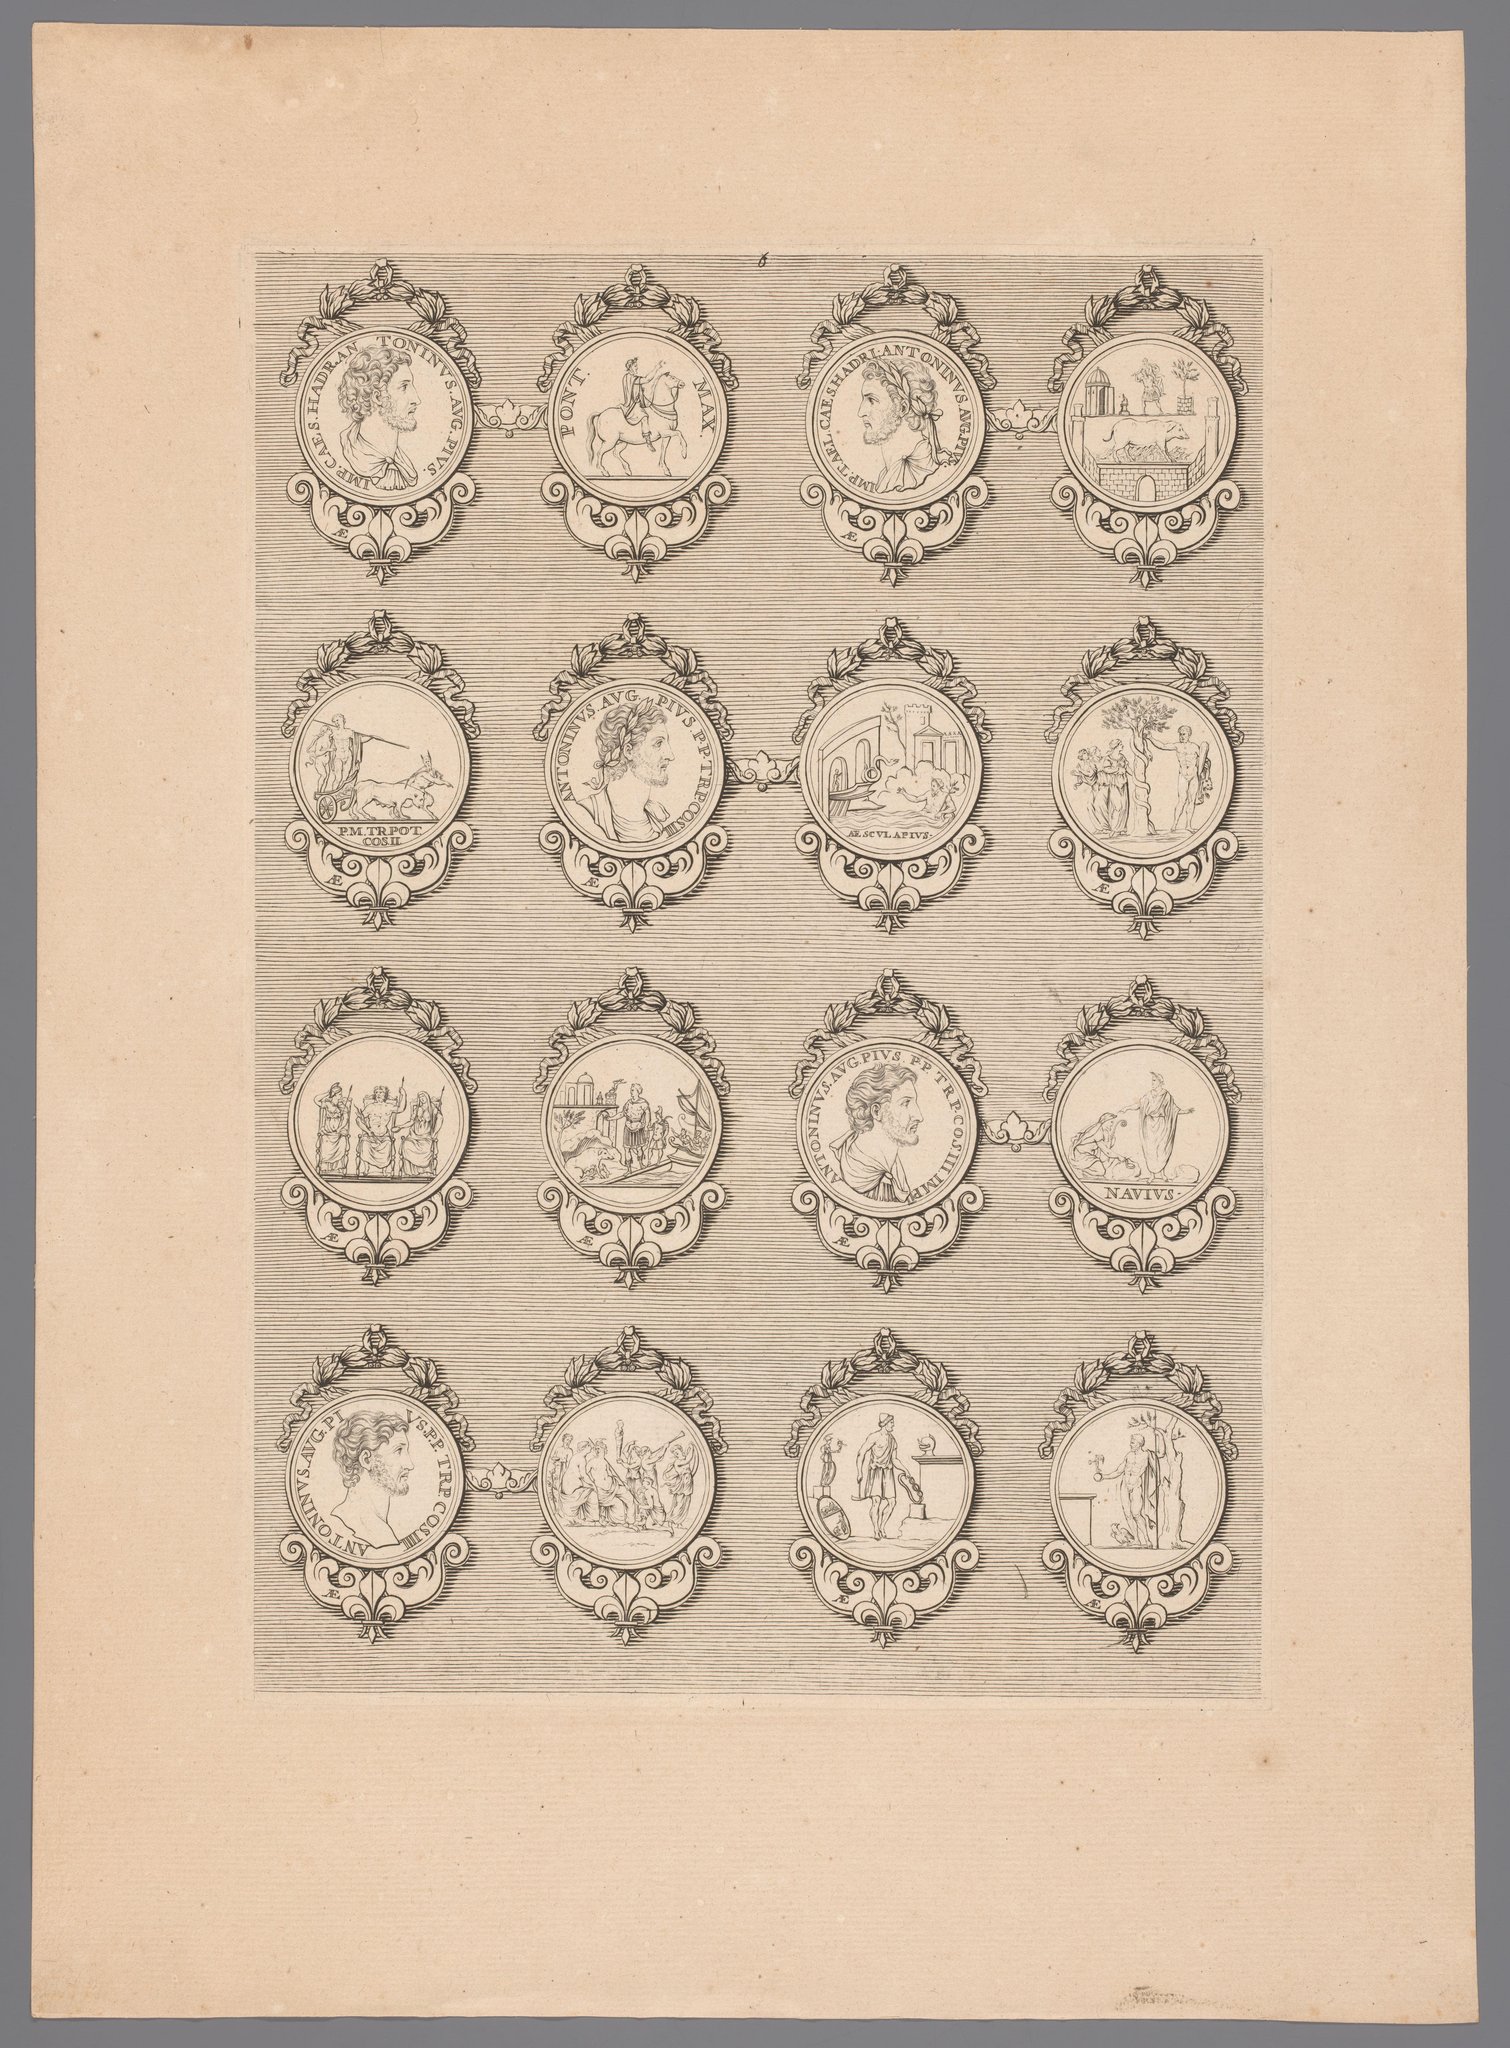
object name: print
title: Penningen in versierde lijsten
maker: simon de la boissière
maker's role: print maker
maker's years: 1637-1682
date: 1647-1682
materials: paper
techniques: etching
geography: france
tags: medal (considered as a piece of sculpture, regardless of its specific function)